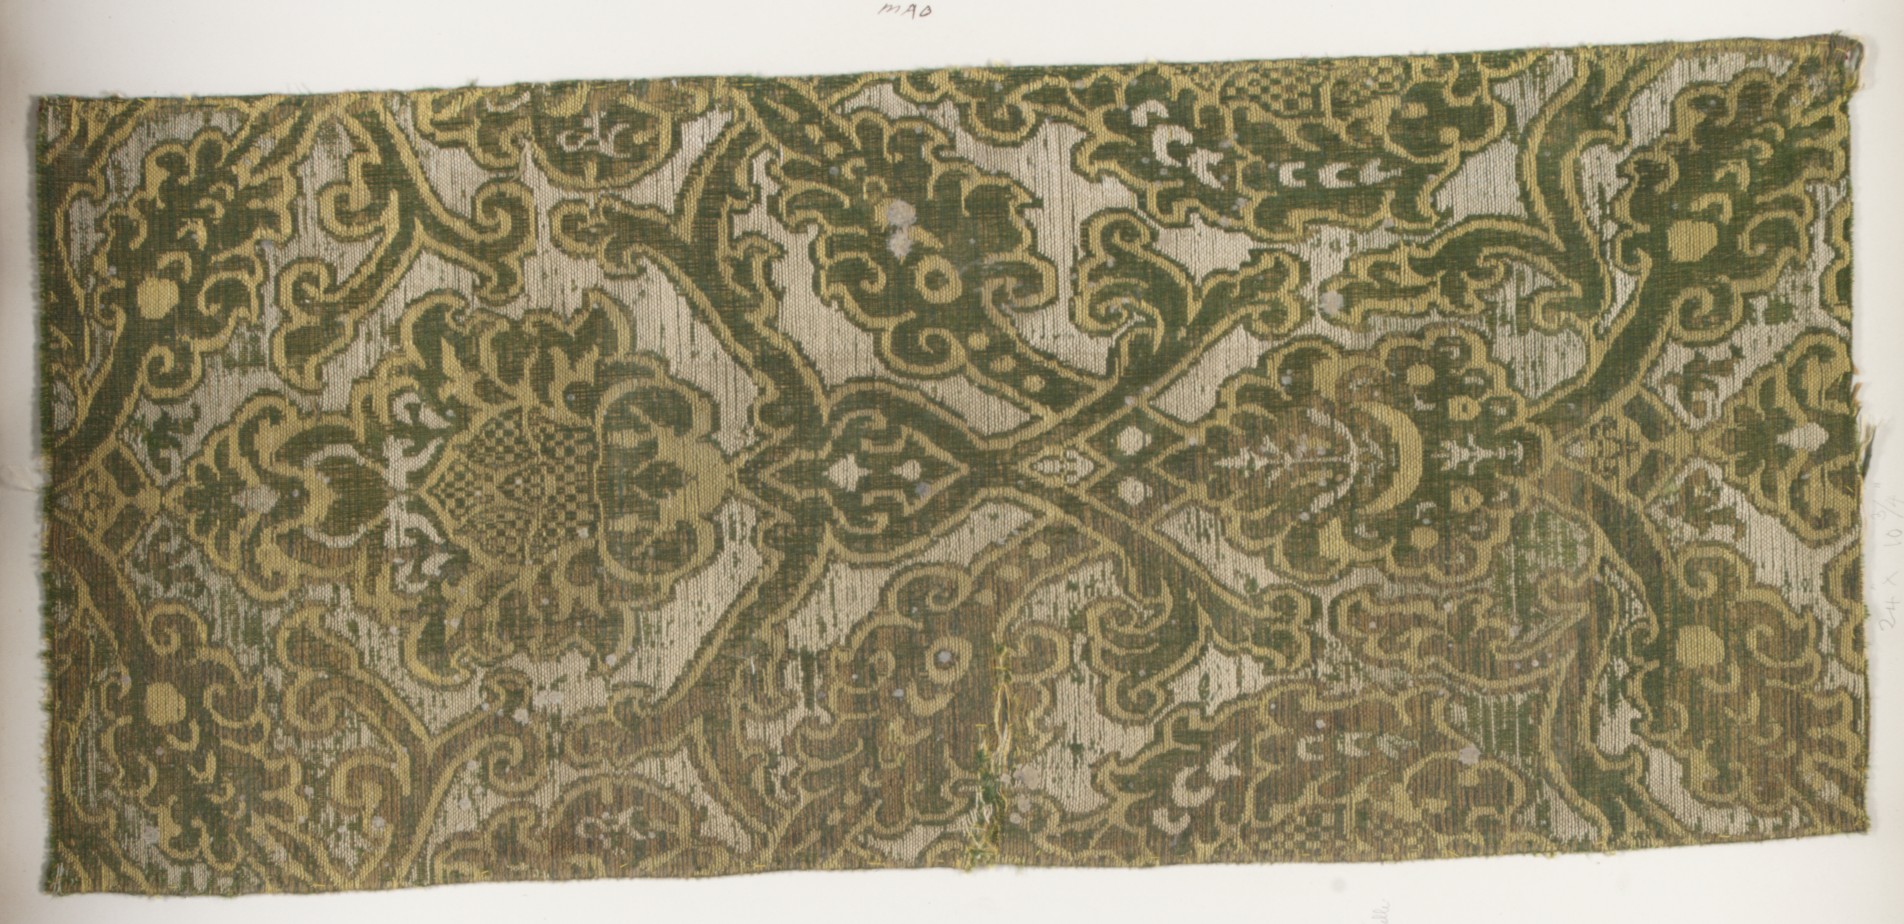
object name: fragment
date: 1601-1700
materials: silk